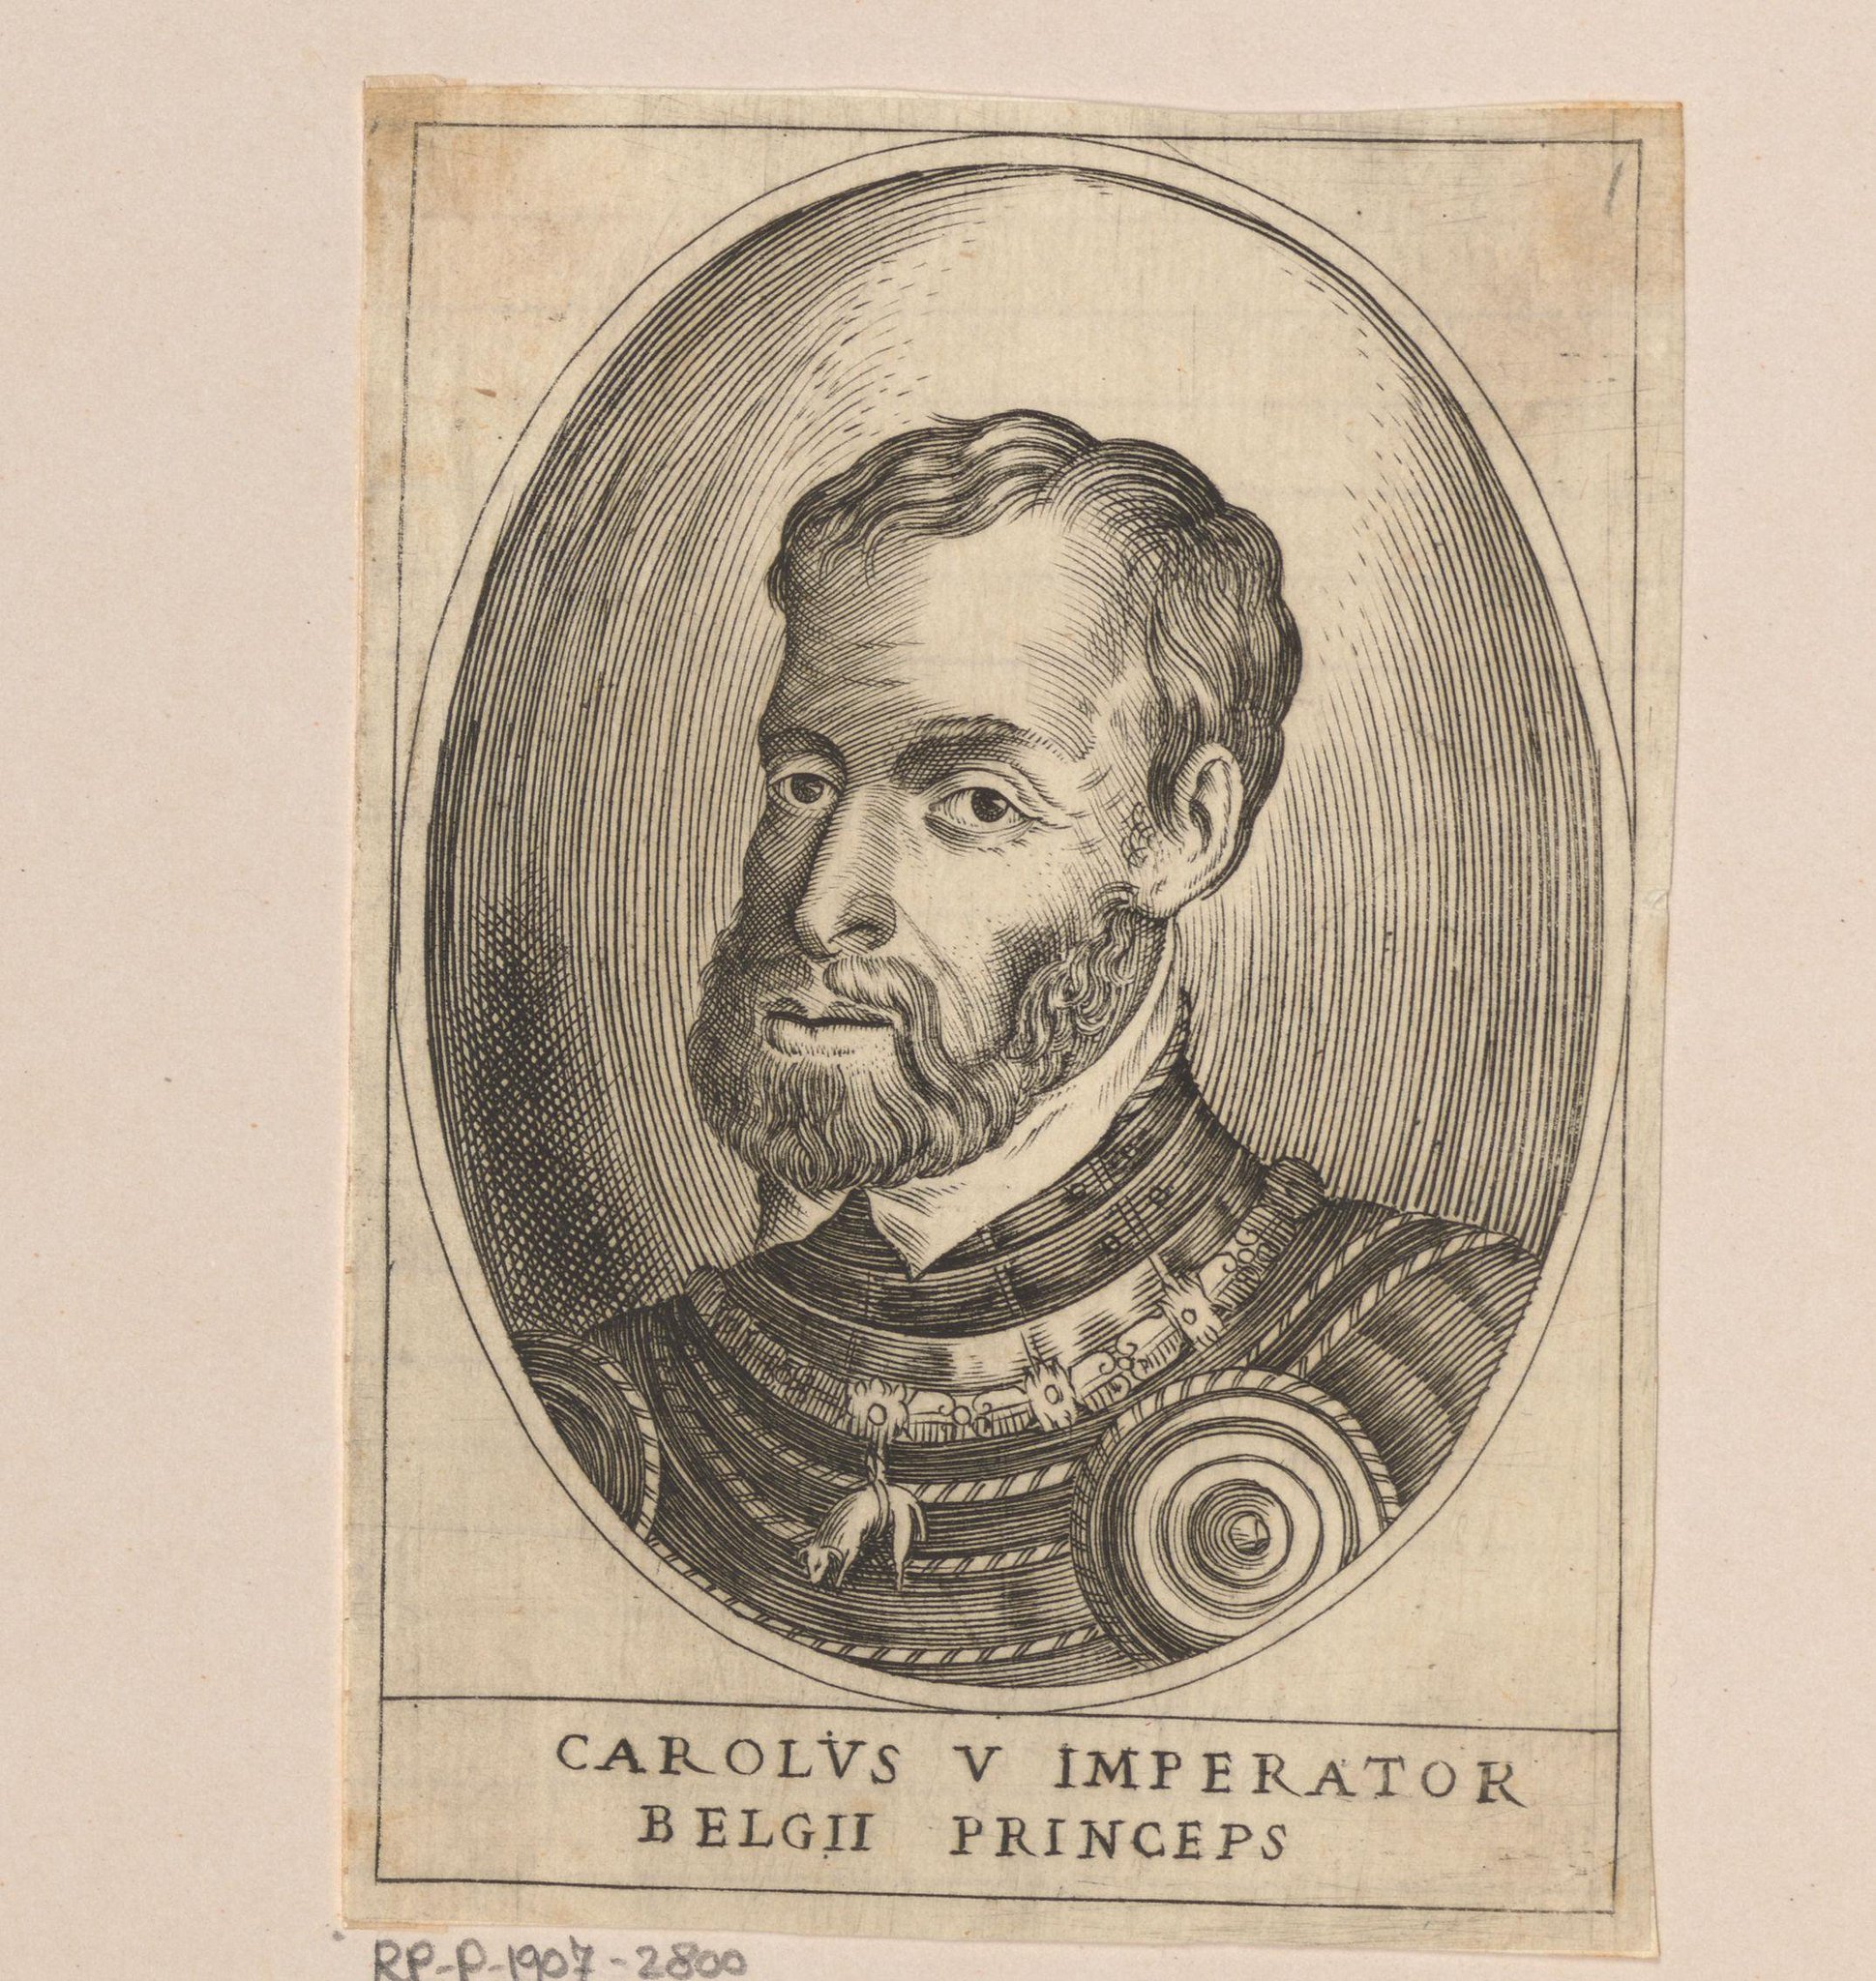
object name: print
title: Portret van keizer Karel V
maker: Anonymous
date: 1650-1699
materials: paper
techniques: engraving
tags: ghent, charles v (holy roman emperor and king of spain), historical persons, knighthood order of the golden fleece, king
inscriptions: collector's mark: Lugt 2228